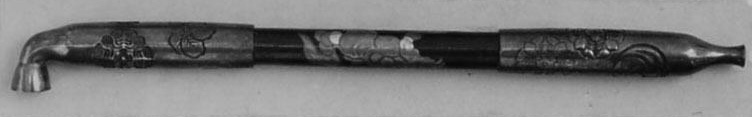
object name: tobacco pipe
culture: japanese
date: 1801-1900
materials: silver